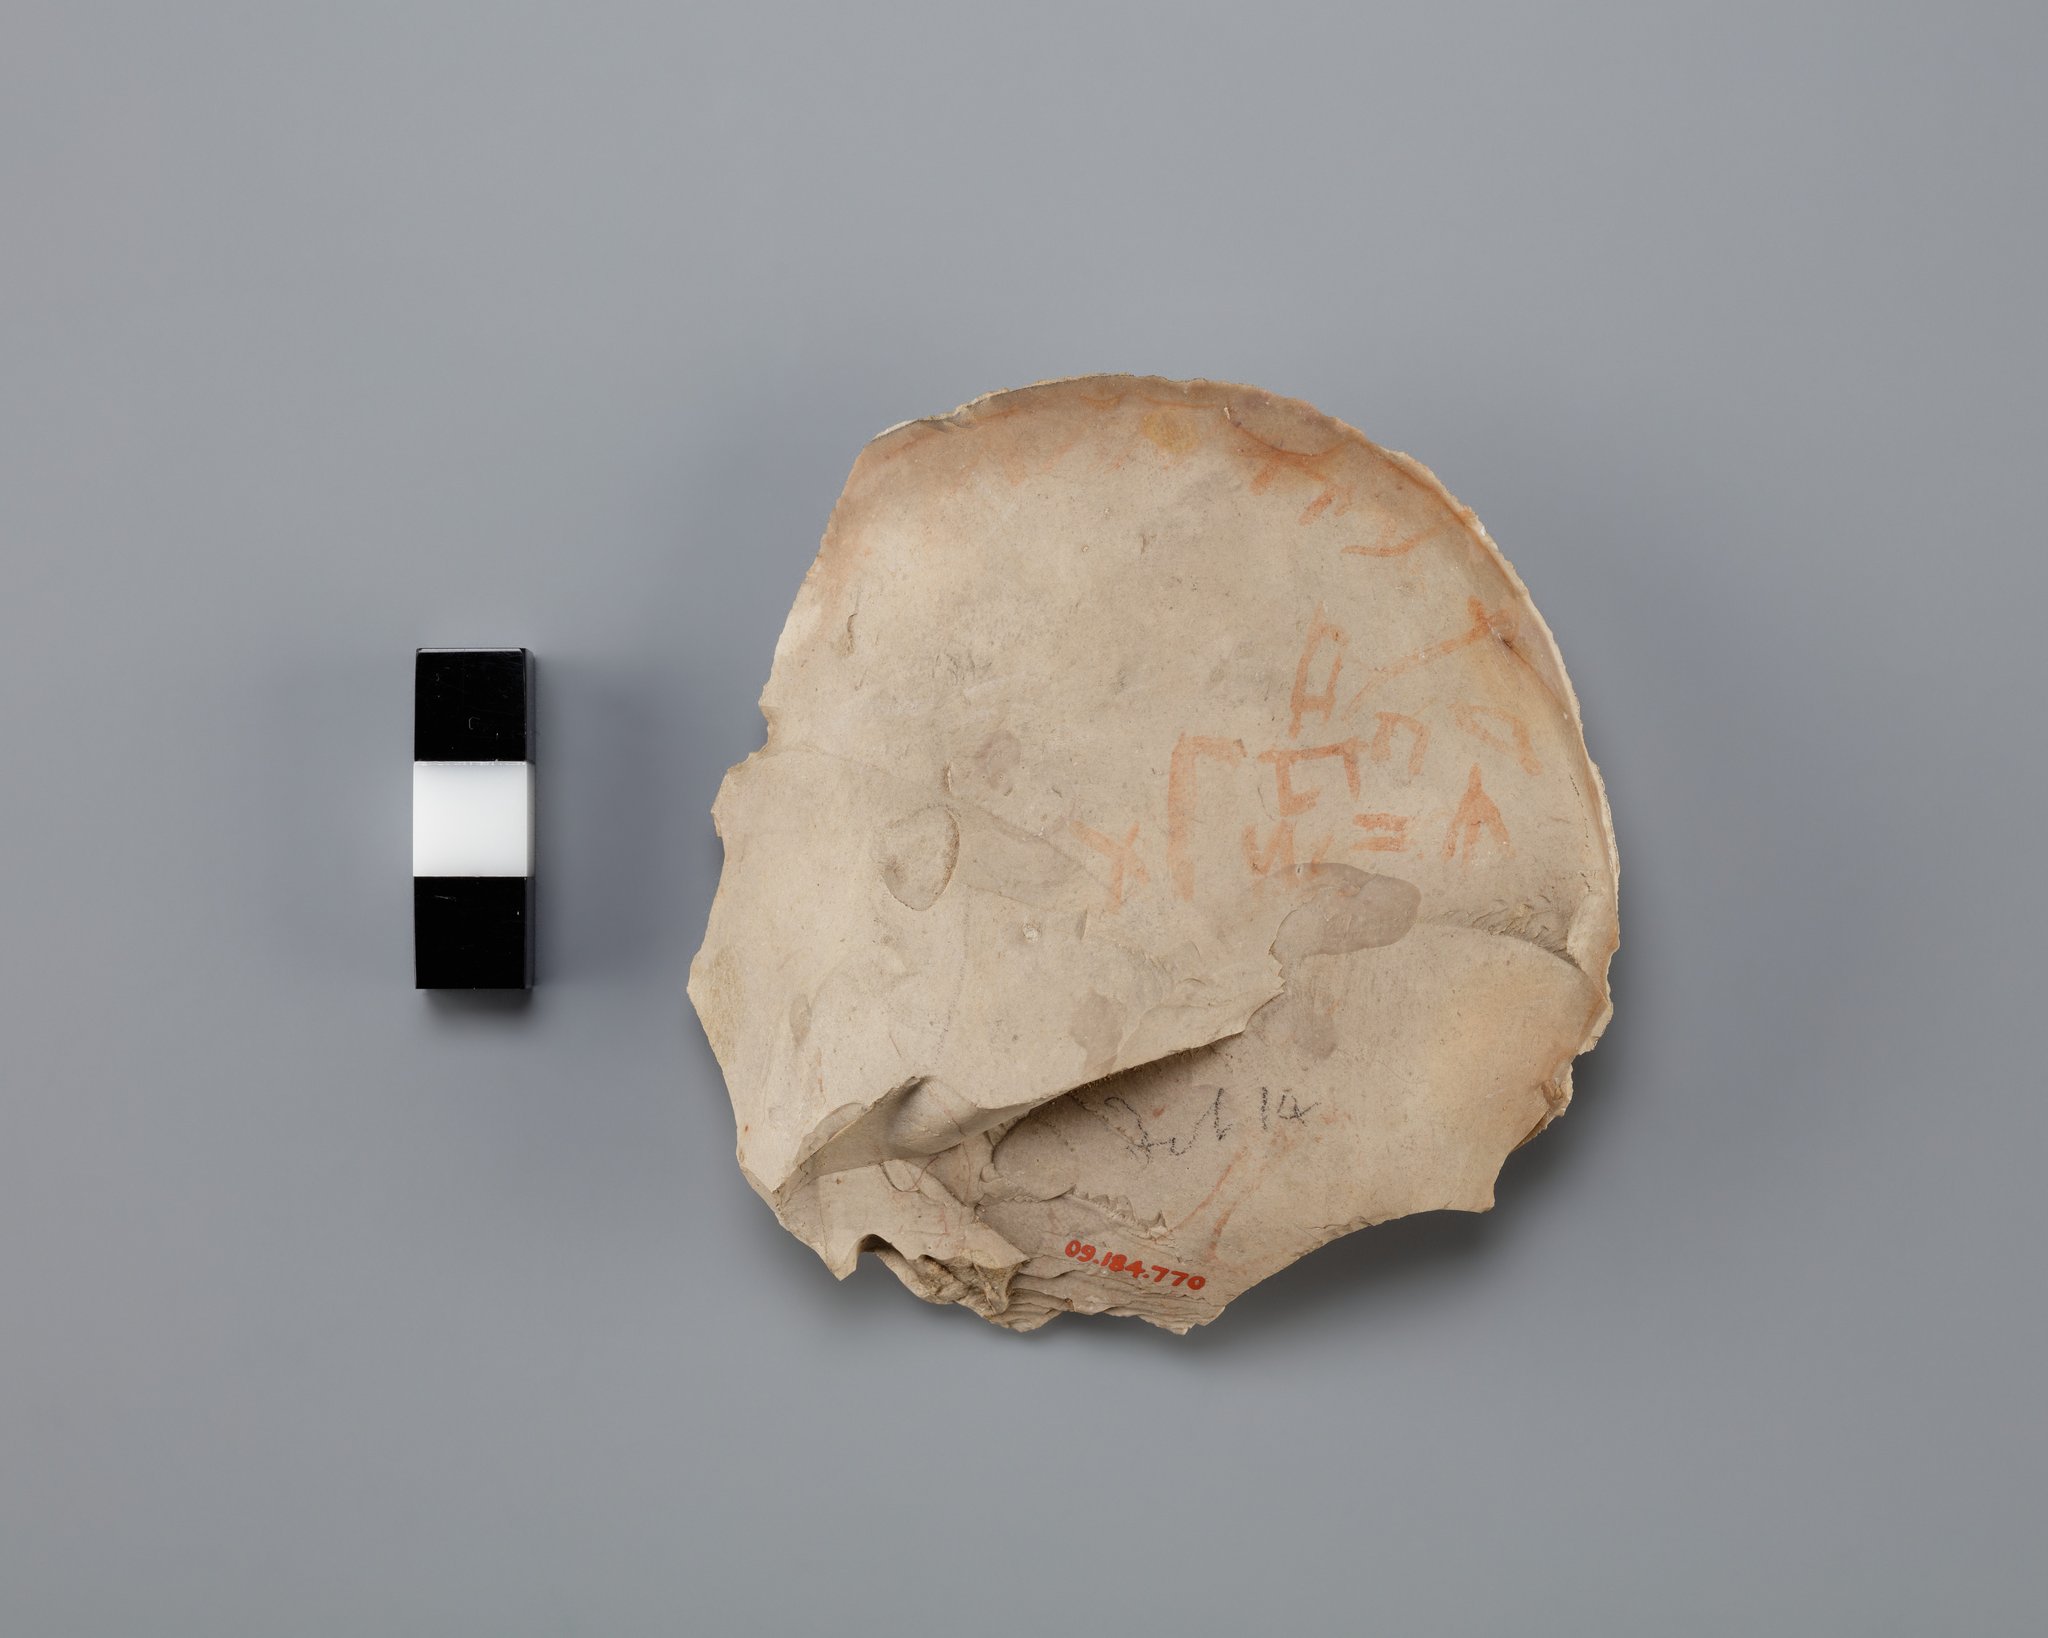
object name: ostracon, hieratic, identity, mark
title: Ostracon inscribed with list of identity marks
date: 1390-1352 BCE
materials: stone, ink, paint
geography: egypt